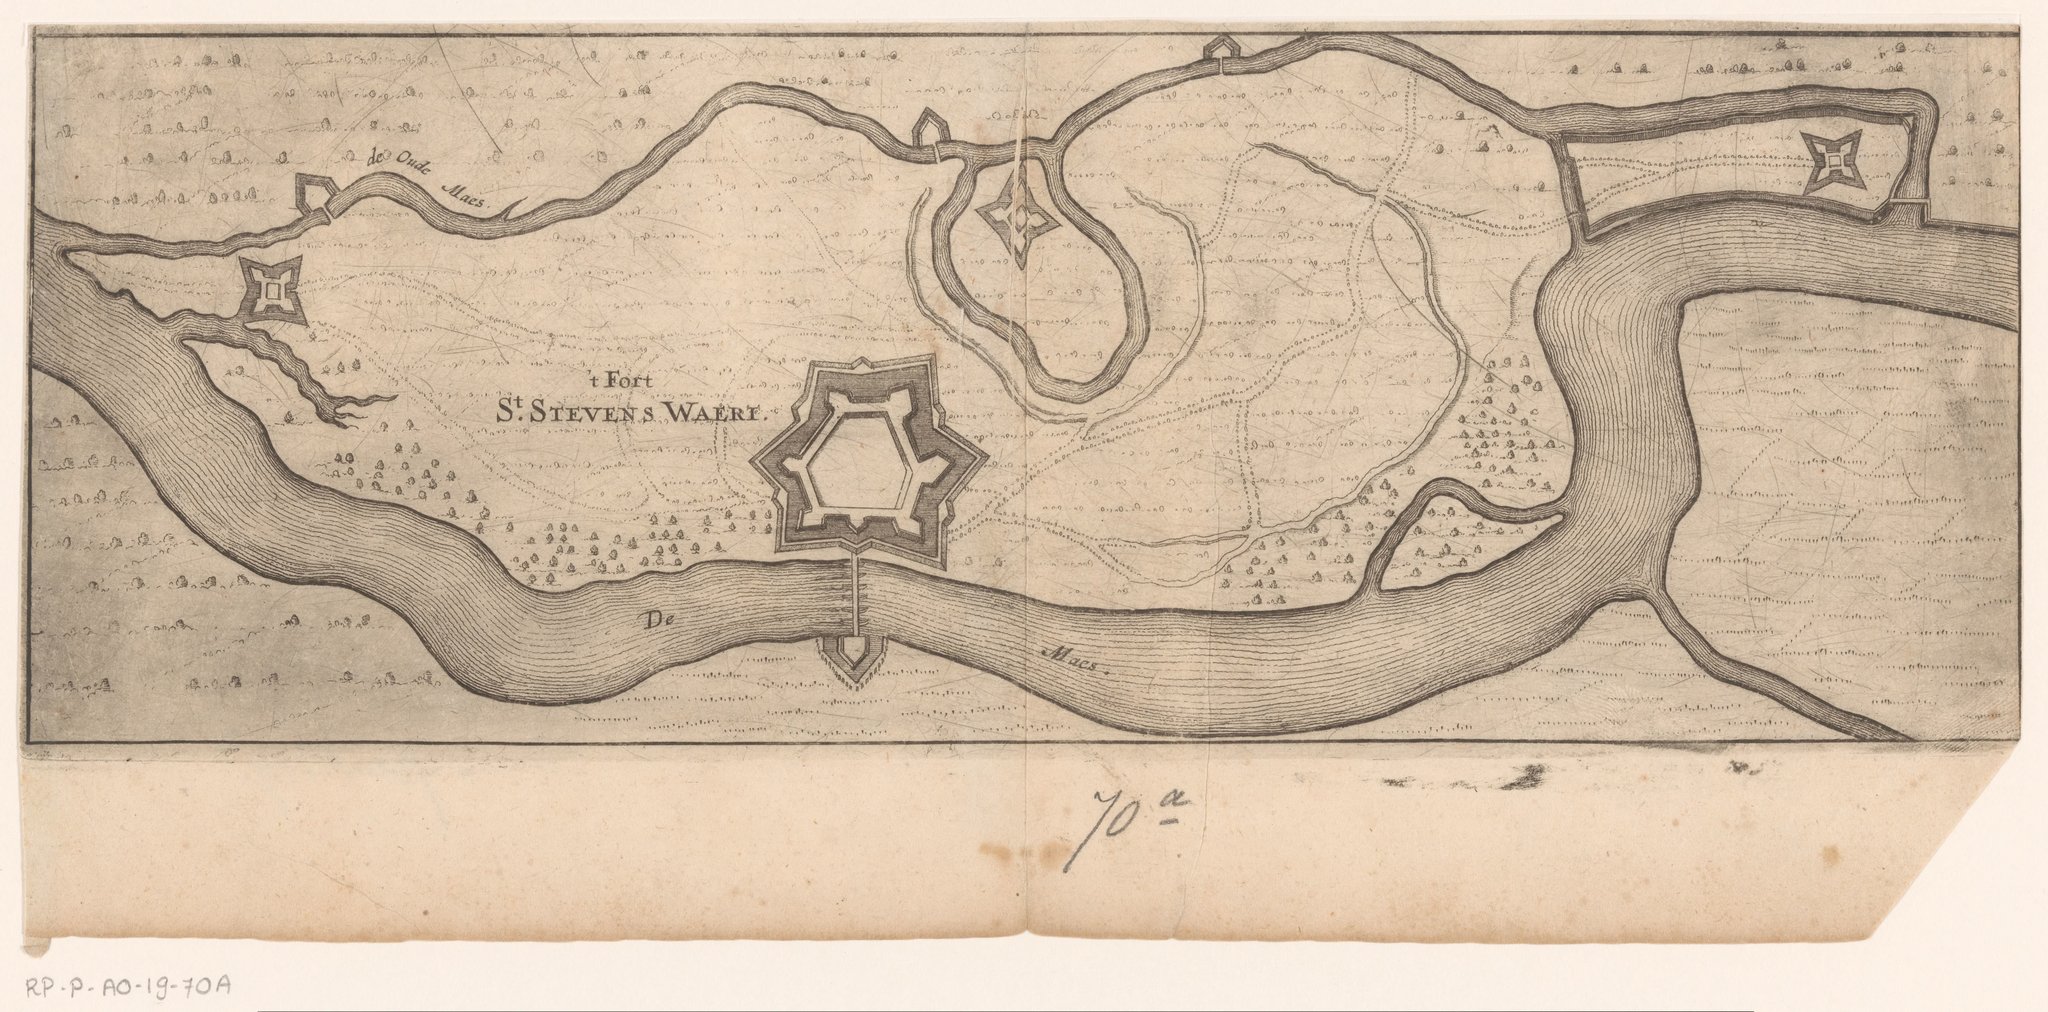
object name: print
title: Vestingplattegrond van Stevensweert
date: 1653-1672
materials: paper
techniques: engraving, etching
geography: arnhem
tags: fortified city, maps of cities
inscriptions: collector's mark: Lugt 2228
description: Prent ook gebruikt in: Slichtenhorst, Arend van. XIV boeken van de Geldersse geschiedenissen (...) Arnhem: Jacob van Biesen, 1653-1654. En in: Slichtenhorst, Arend van. Cartes géographiques du duché de Gueldre et comté de Zutphen (...) Arnhem: Jacob van Biesen, 1672.